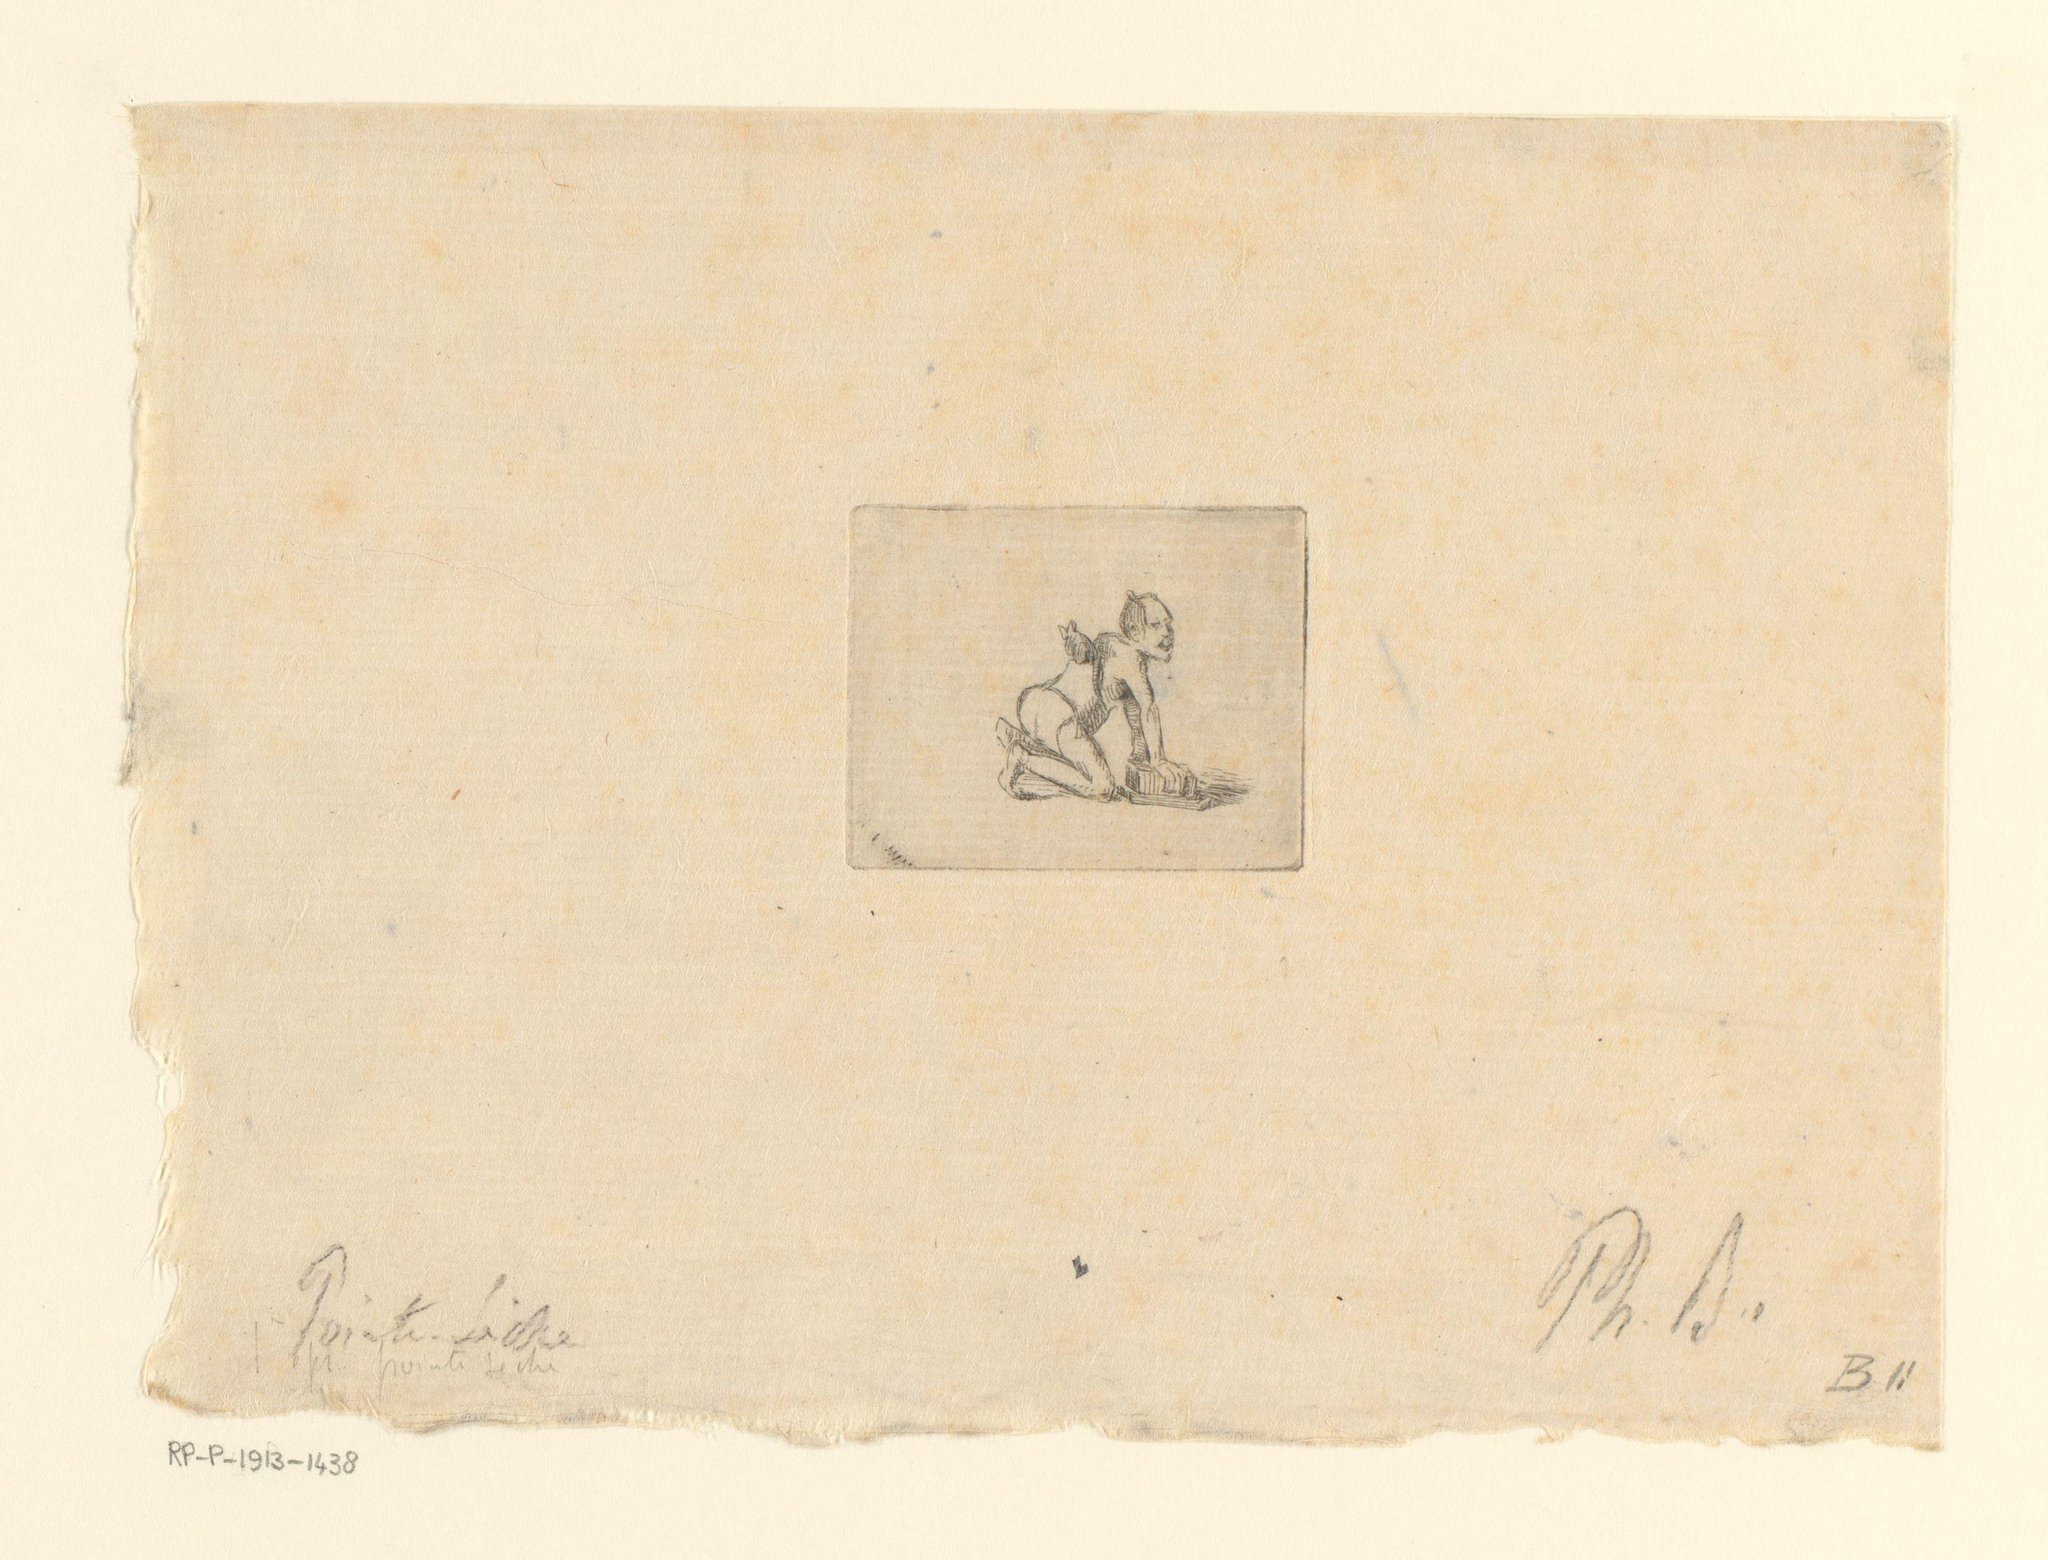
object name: print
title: Netsuke van een man met een rattenval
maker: philippe burty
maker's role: print maker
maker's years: 1830-1890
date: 1840-1890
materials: paper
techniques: drypoint, intaglio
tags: carving ~ applied arts, piece of sculpture, reproduction of a piece of sculpture, mouse trap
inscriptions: inscription: ‘Pointe-Sèche Ph.B.’, collector's mark: Lugt 2233